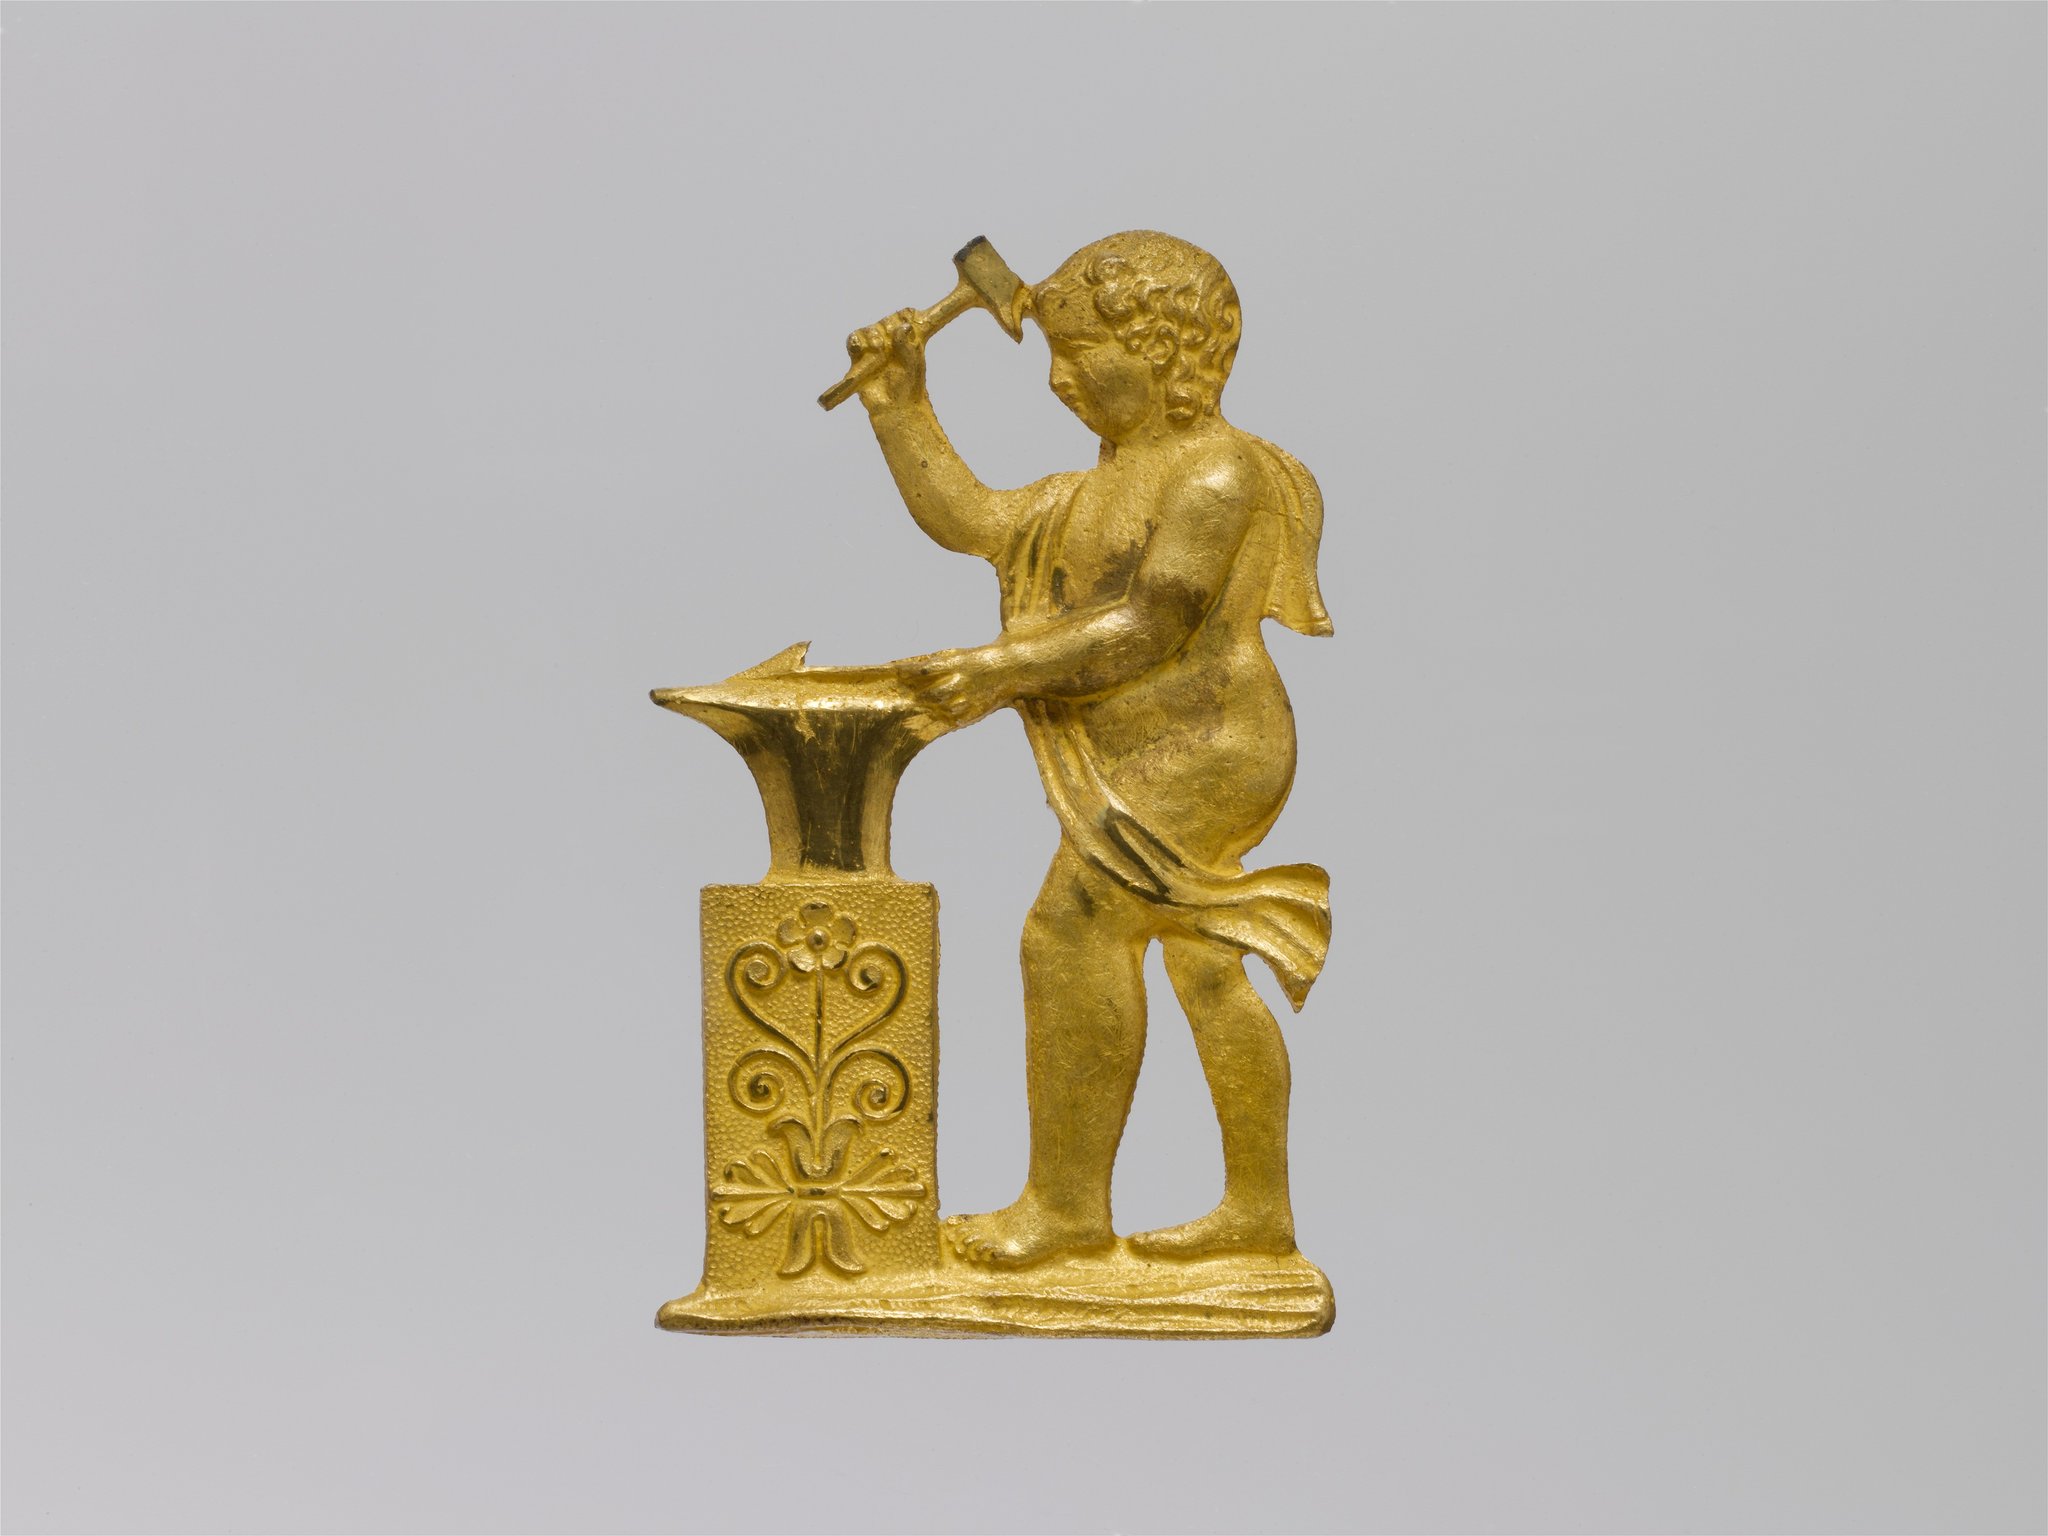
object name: appliqué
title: Smithy Cupid Appliqué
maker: henry kellam hancock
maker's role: retailer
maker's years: 1816-1851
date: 1810-1830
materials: brass, lacquer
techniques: casting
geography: france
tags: cupid